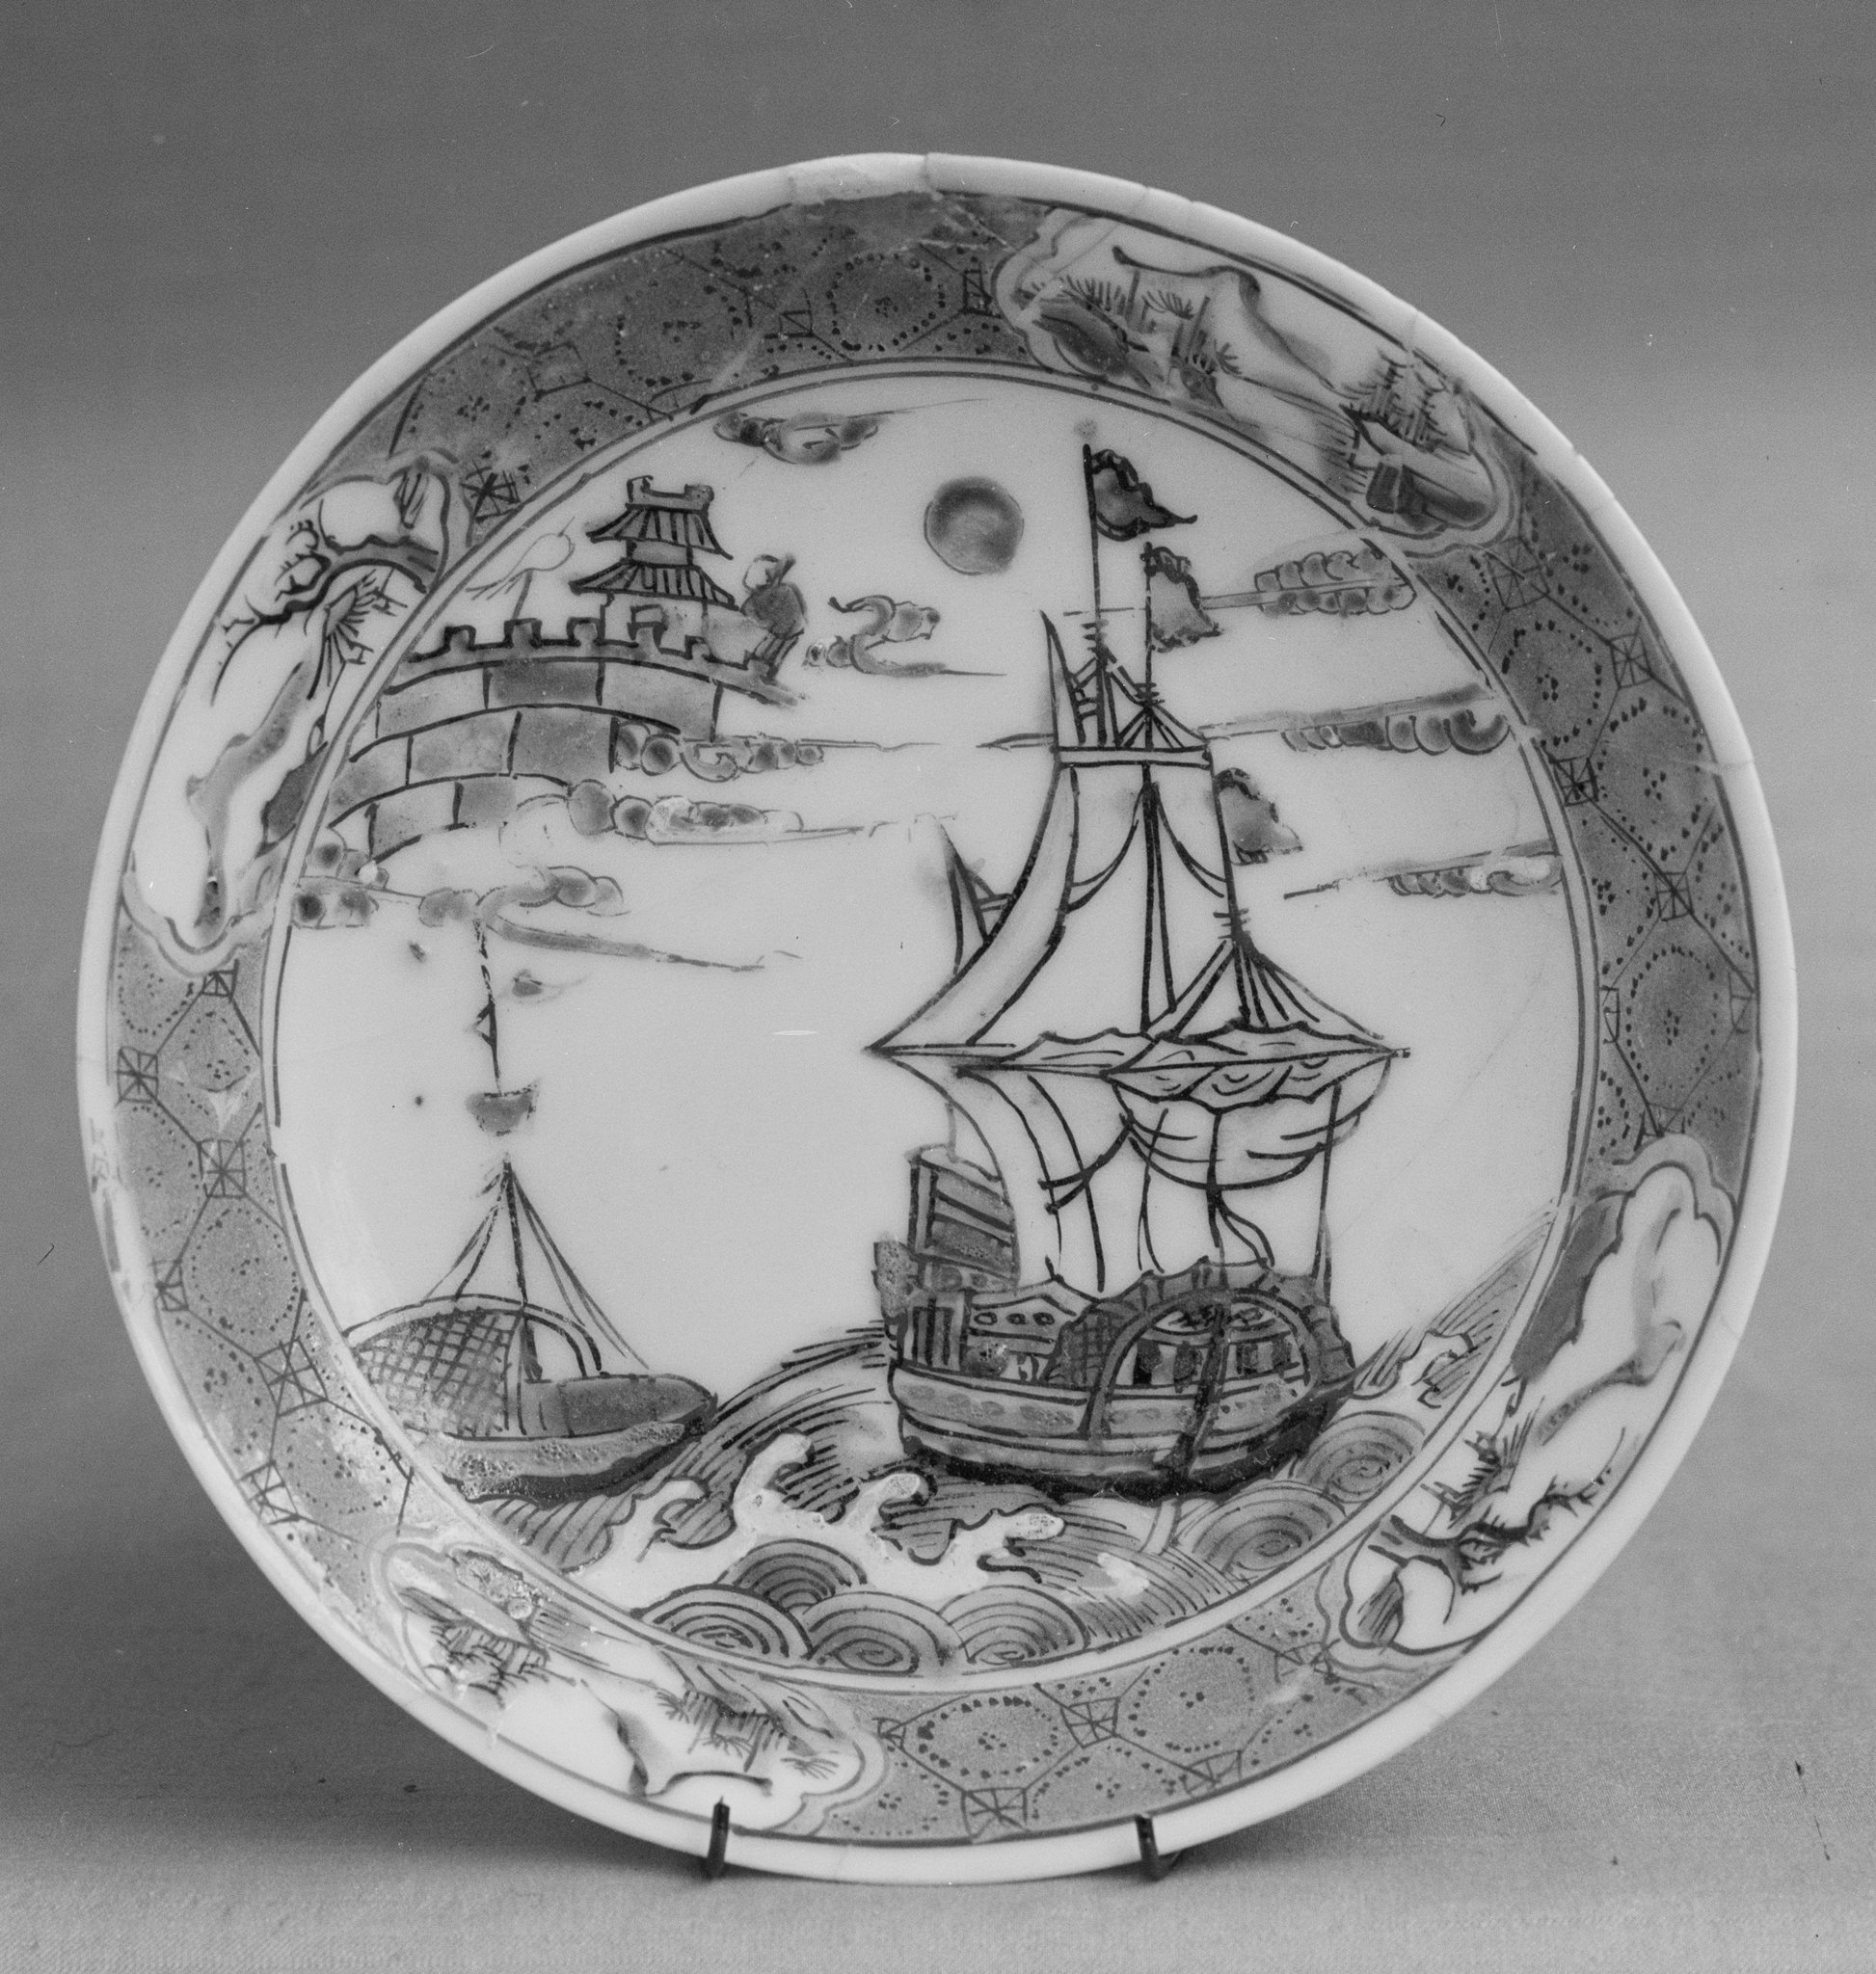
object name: saucer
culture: chinese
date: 1736-1795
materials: porcelain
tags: boats